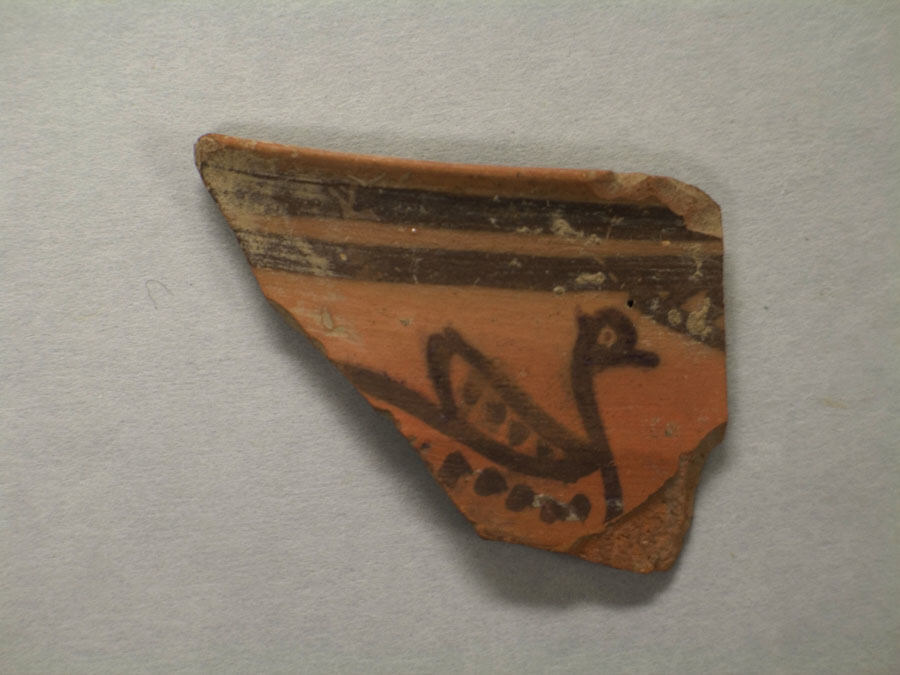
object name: shard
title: Shard: Bird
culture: pakistani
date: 301-500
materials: terracotta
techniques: painting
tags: birds,gandhara